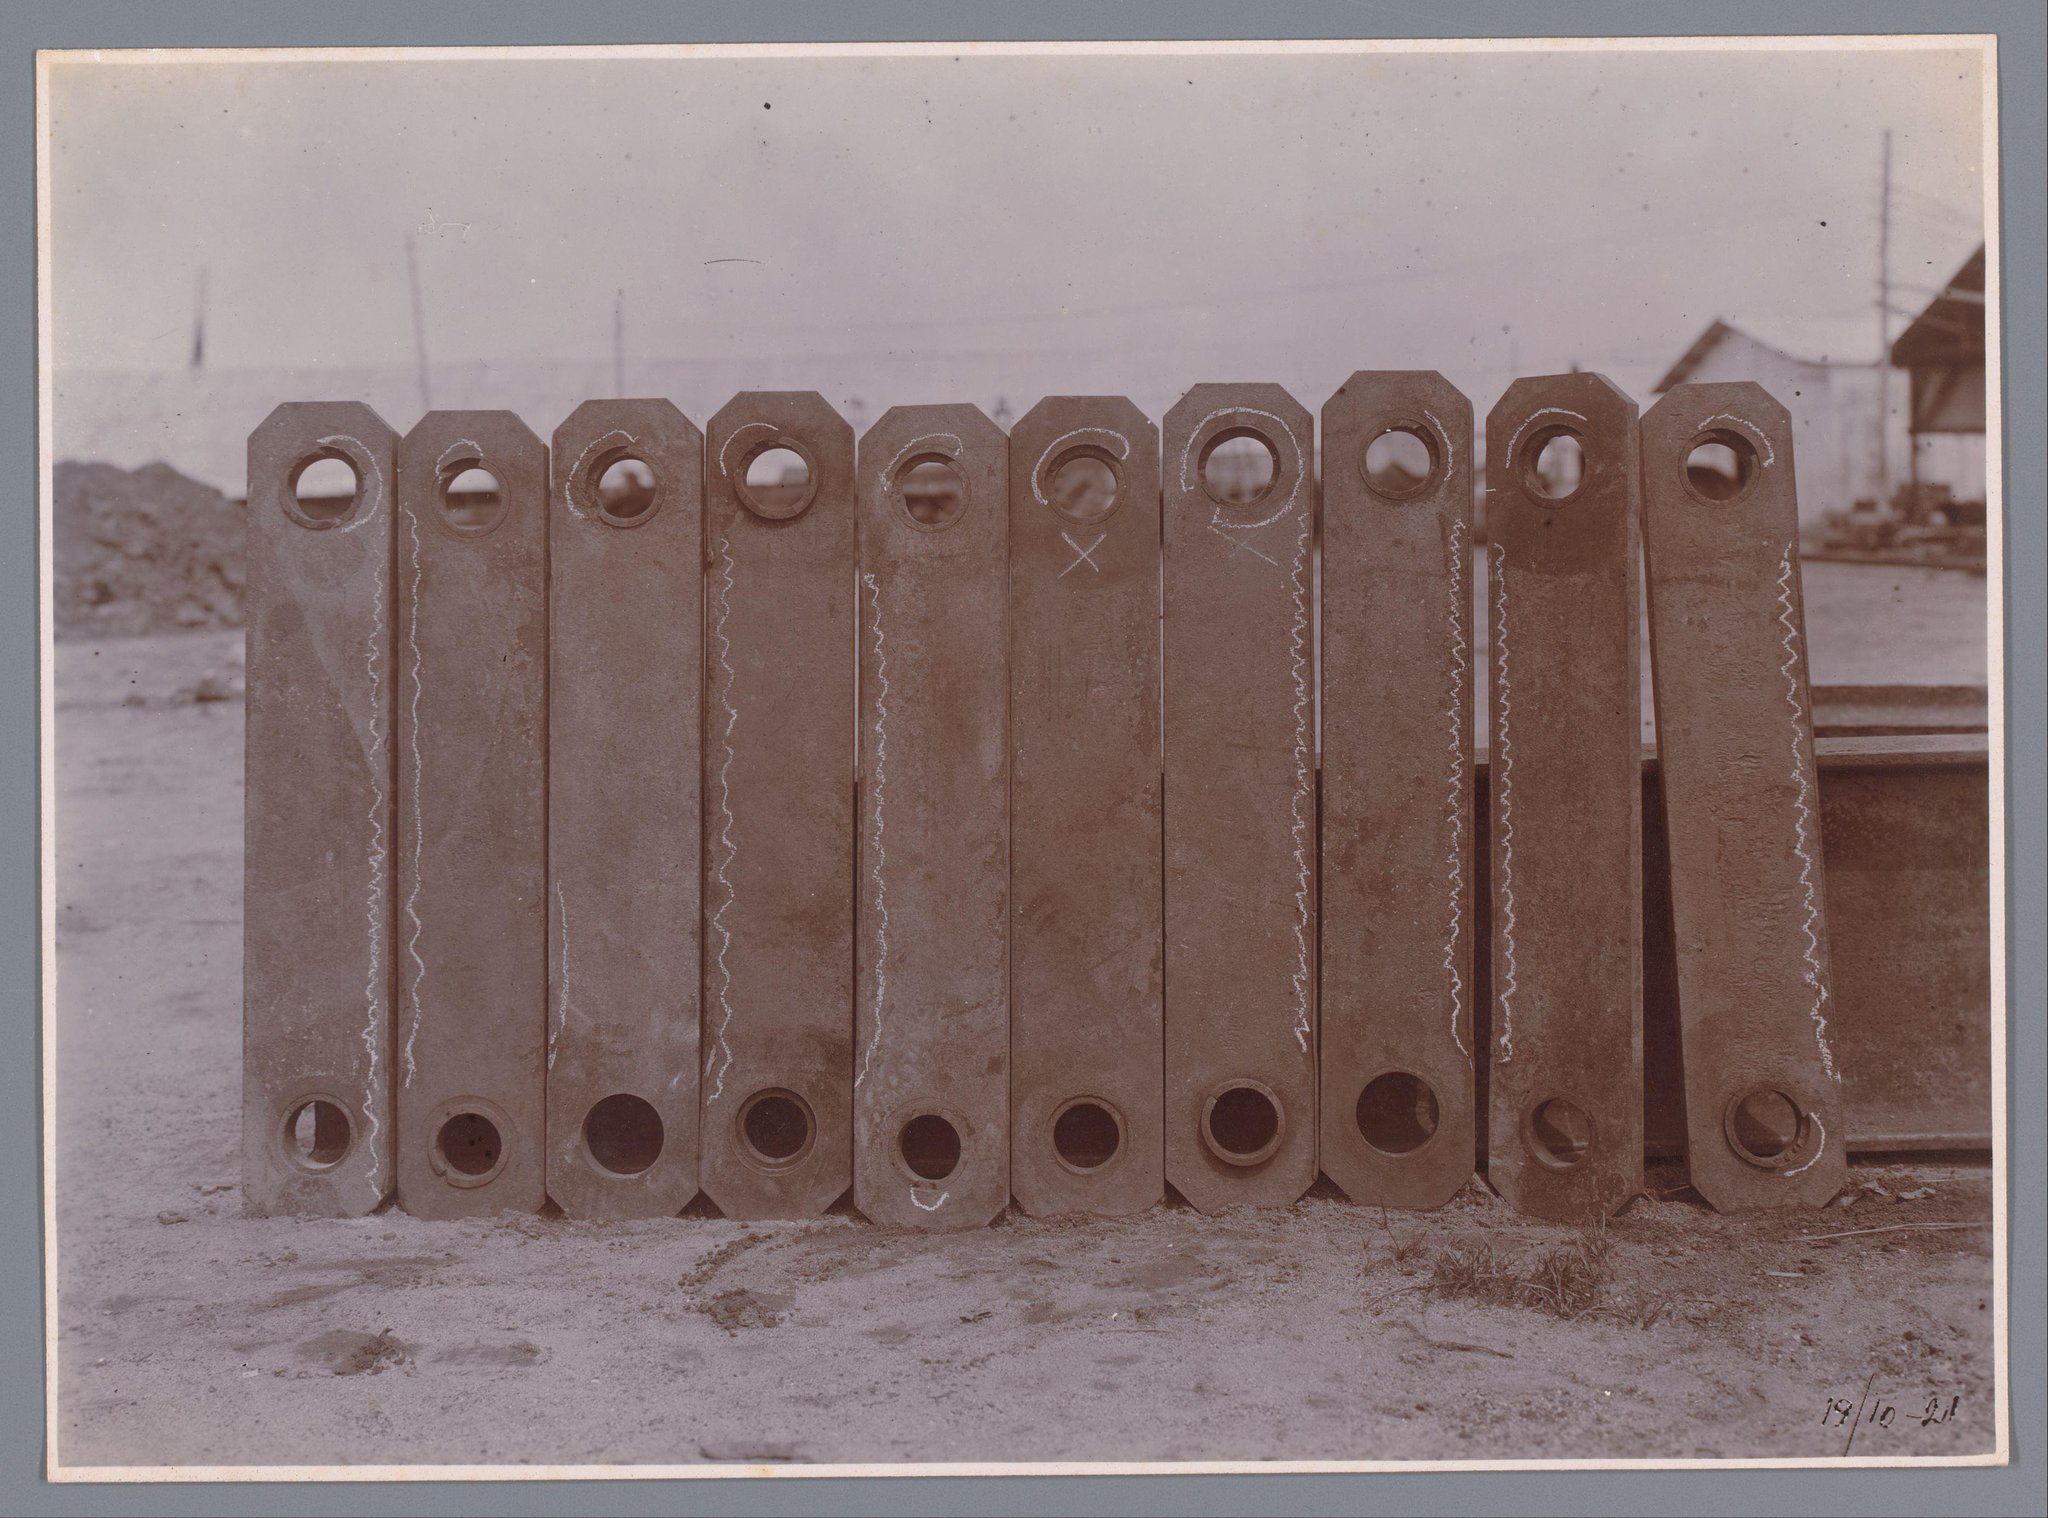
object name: photograph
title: Schalmen emmerketting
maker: Anonymous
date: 1921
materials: photographic support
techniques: gelatin silver print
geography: belawan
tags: harbour, building-site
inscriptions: inscription: ‘No. 70 / Oceaanhaven Belawan / Schalmen emmerketting’, date: ‘17/10-21’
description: Onderdelen van de emmerketting van een baggerschip. Genummerd: 70. Onderdeel van de groep van losse foto's over de aanleg van de haven Belawan aan de kust voor Medan, Sumatra 1921-1922.